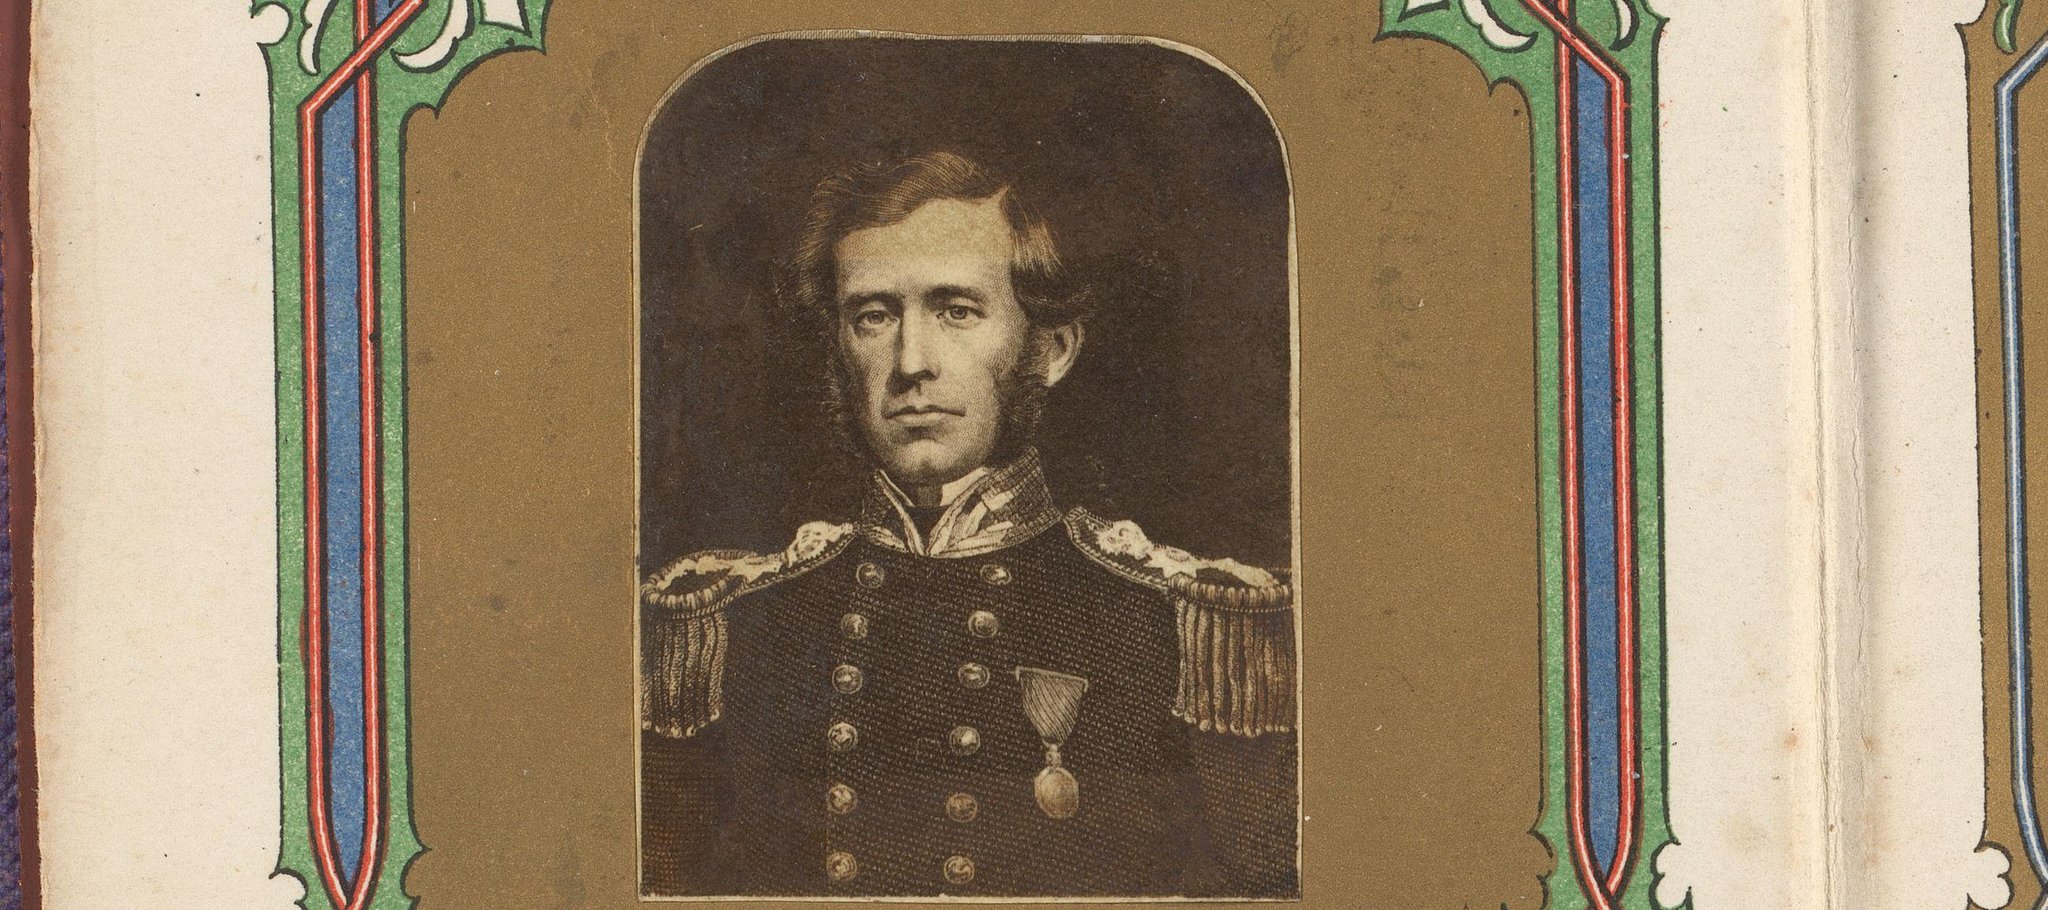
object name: photograph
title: Fotoreproductie van een gegraveerd portret van Sir Francis Leopold McClintock, scheepskapitein bij de Royal Navy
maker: Anonymous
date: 1857-1862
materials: paper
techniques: albumen print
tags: london, historical persons, commander-in-chief, admiral